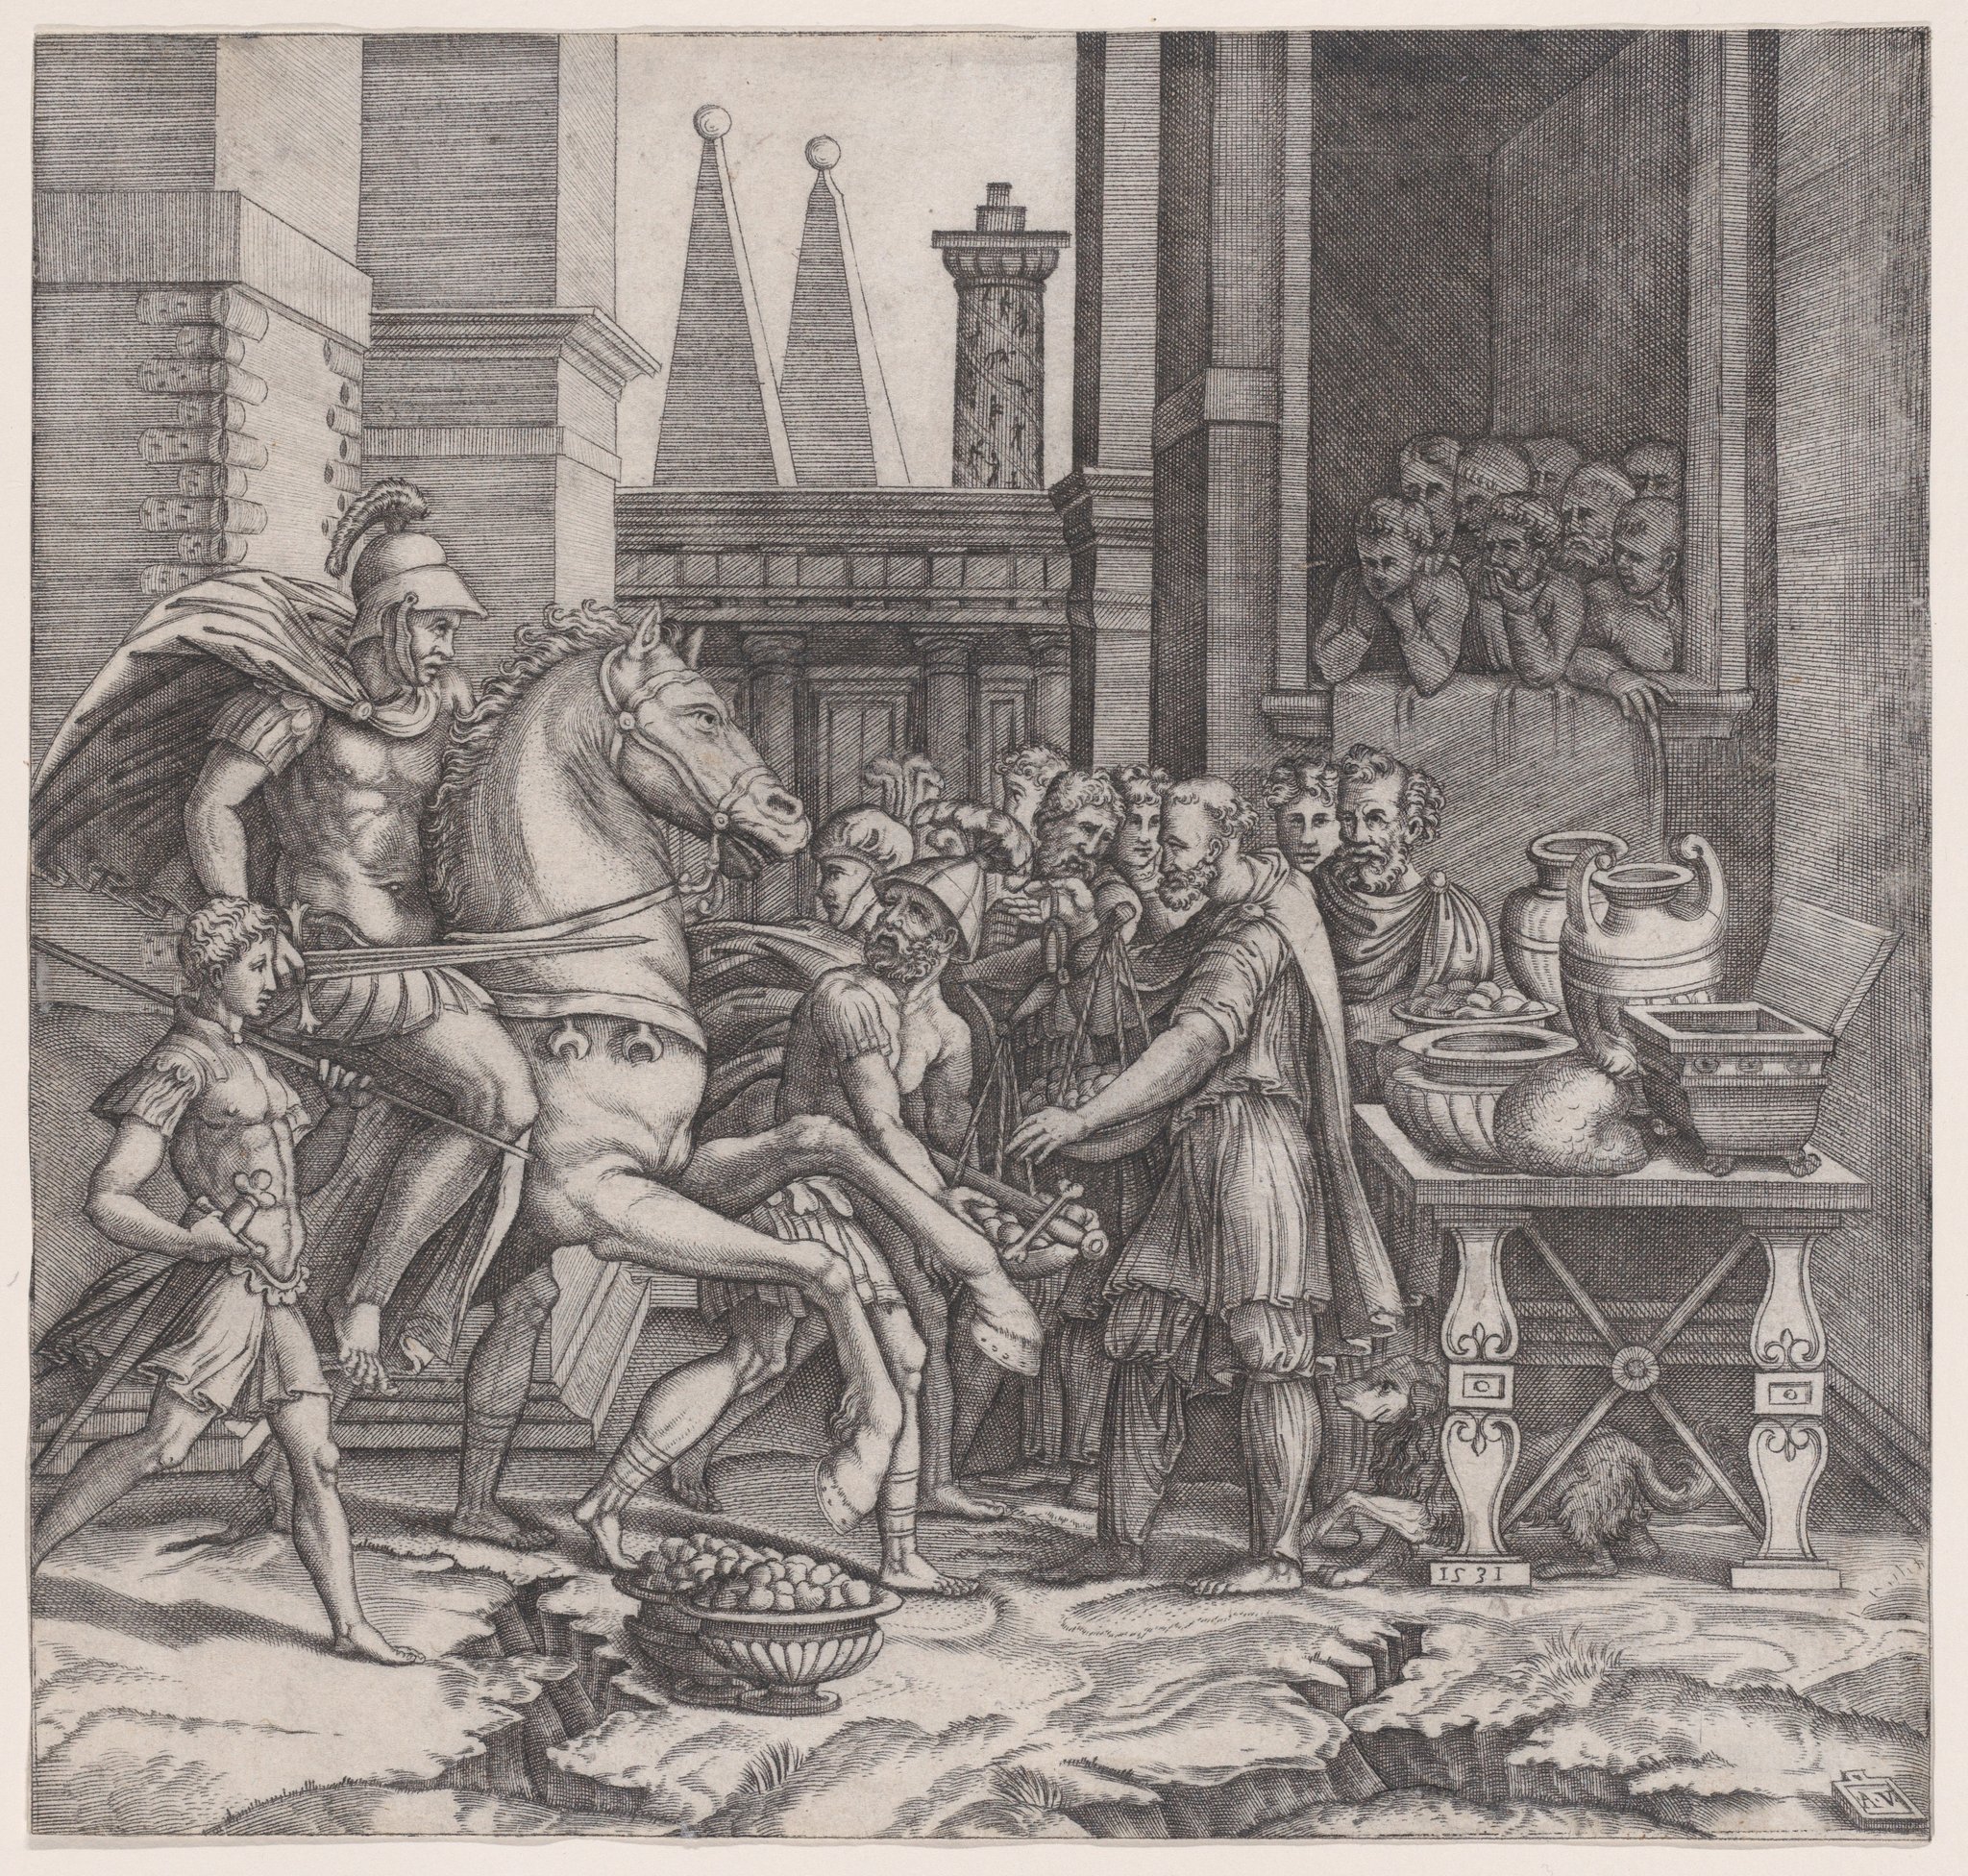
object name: print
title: Camillus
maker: agostino veneziano (agostino dei musi)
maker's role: artist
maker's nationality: italian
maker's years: 1490-1536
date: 1531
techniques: engraving